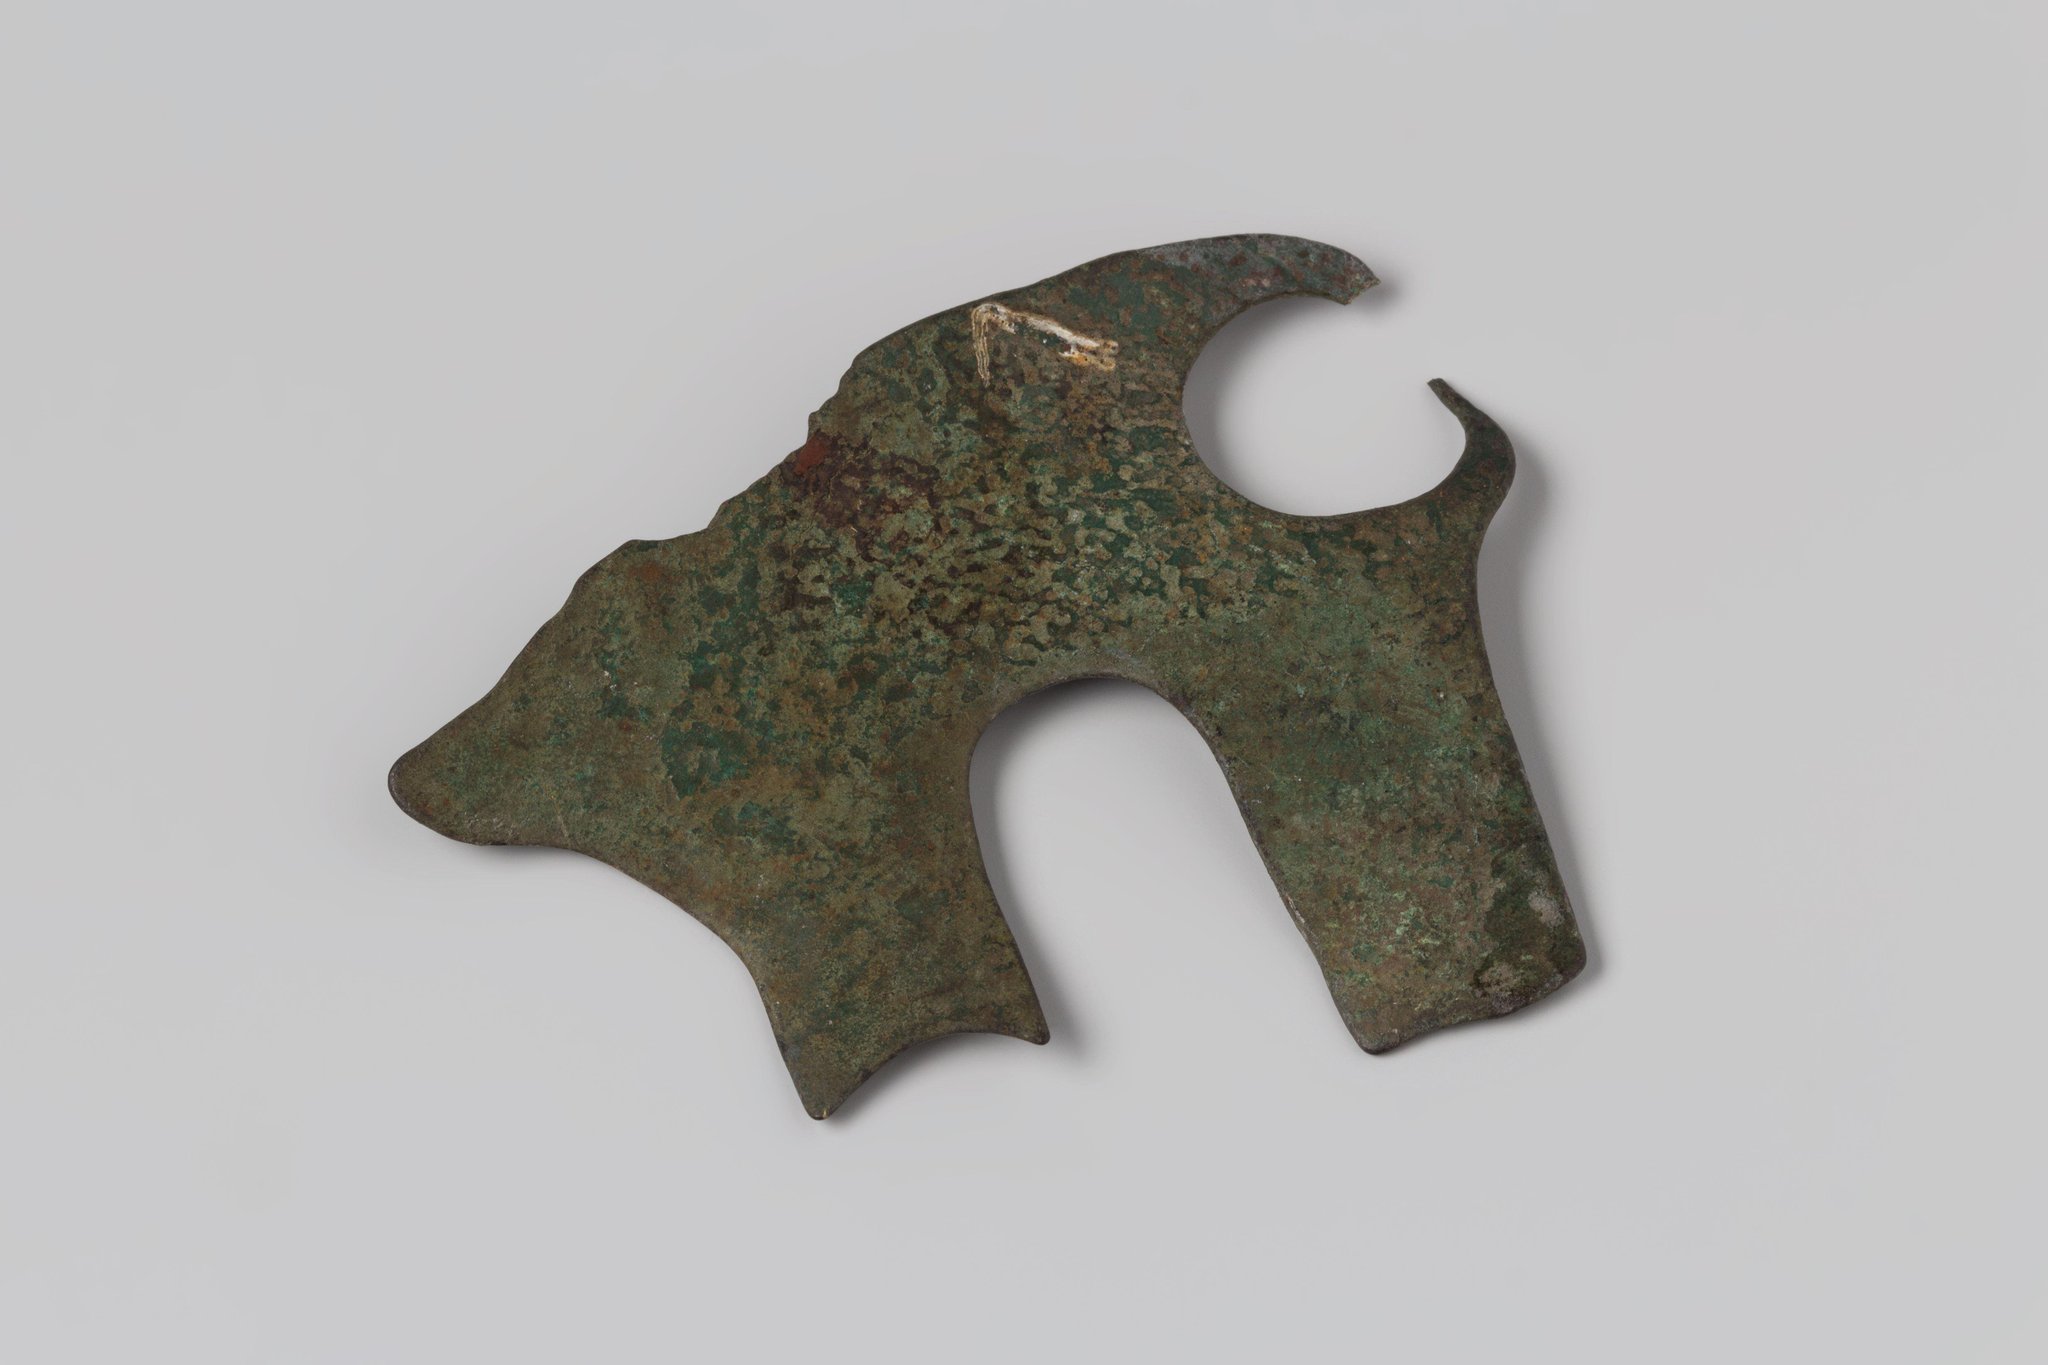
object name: scheepswrakvondst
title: Fragment plaatwerk van koper uit het wrak van de Oost-Indiëvaarder Hollandia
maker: Anonymous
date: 1700-1743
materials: copper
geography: netherlands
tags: verenigde oostindische compagnie, hollandia (schip), annet